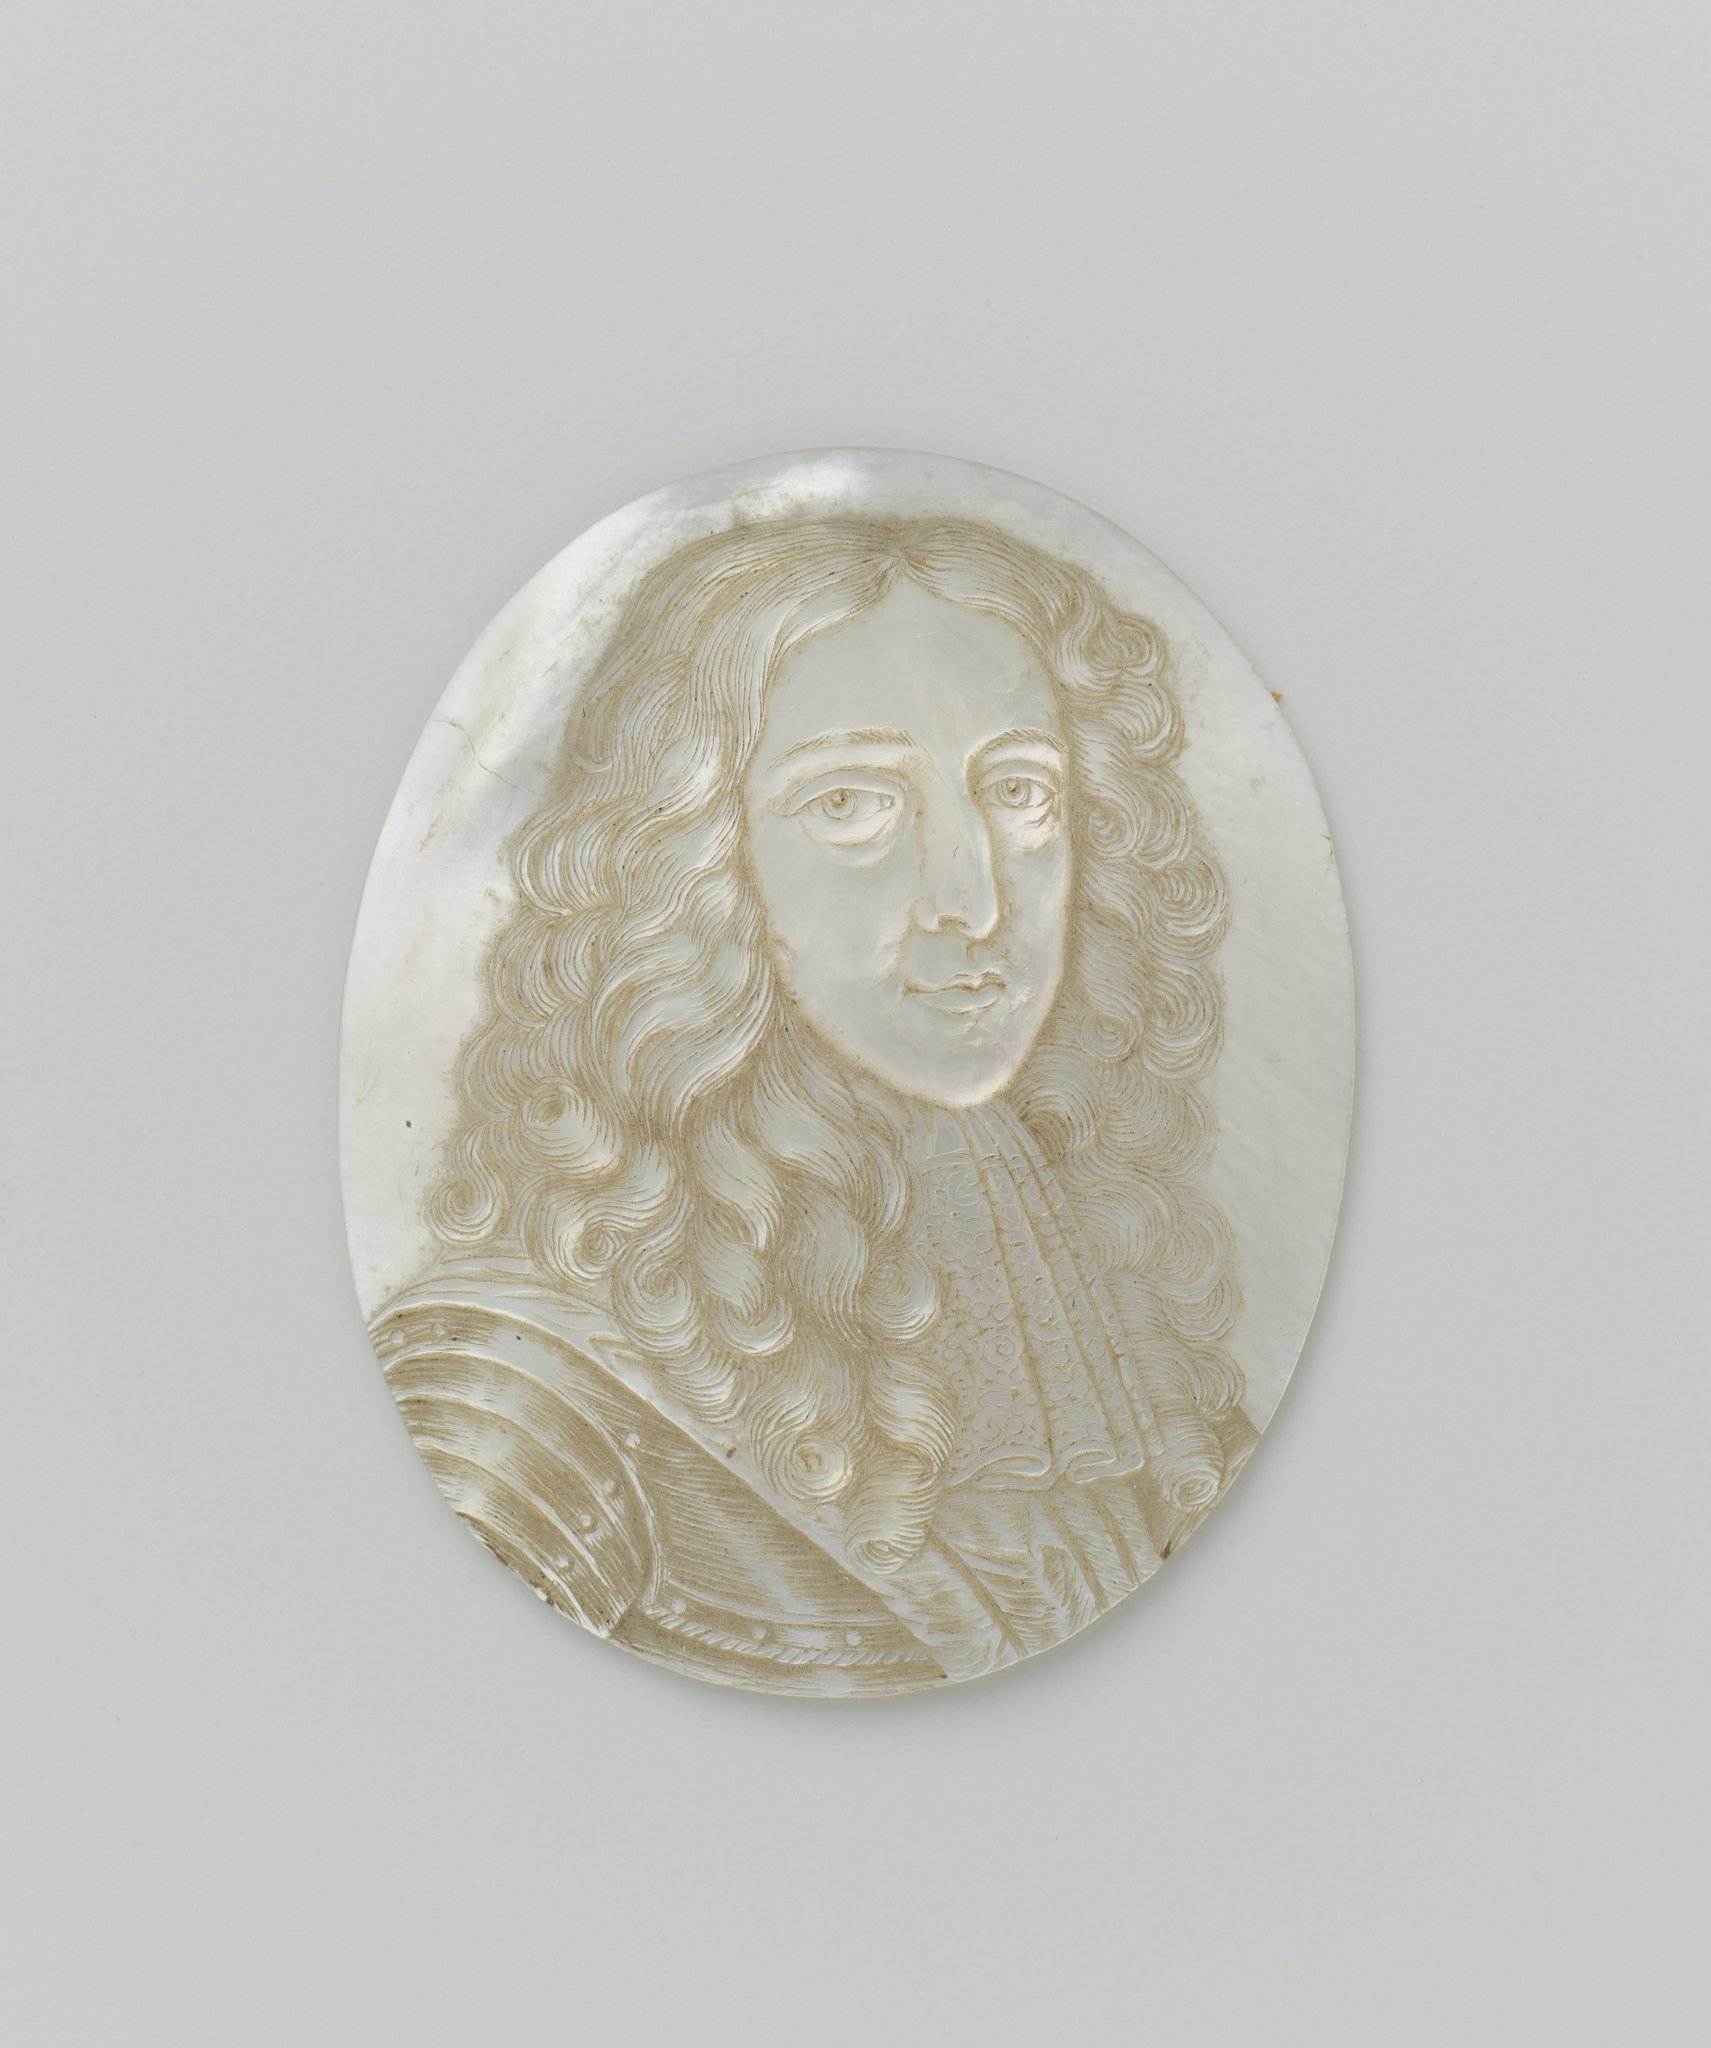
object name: plaque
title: Reliëf met Willem III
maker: Anonymous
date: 1680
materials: mother of pearl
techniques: cutting, engraving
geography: netherlands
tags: the hague, william iii (prince of orange and king of england, scotland, and ireland)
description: Orange souvenirs. William III's popularity, and later also that of his wife Mary, gave rise to a wide variety of objects sporting their pictures: medallions, glasses, tiles, cutlery and Delftware pottery.